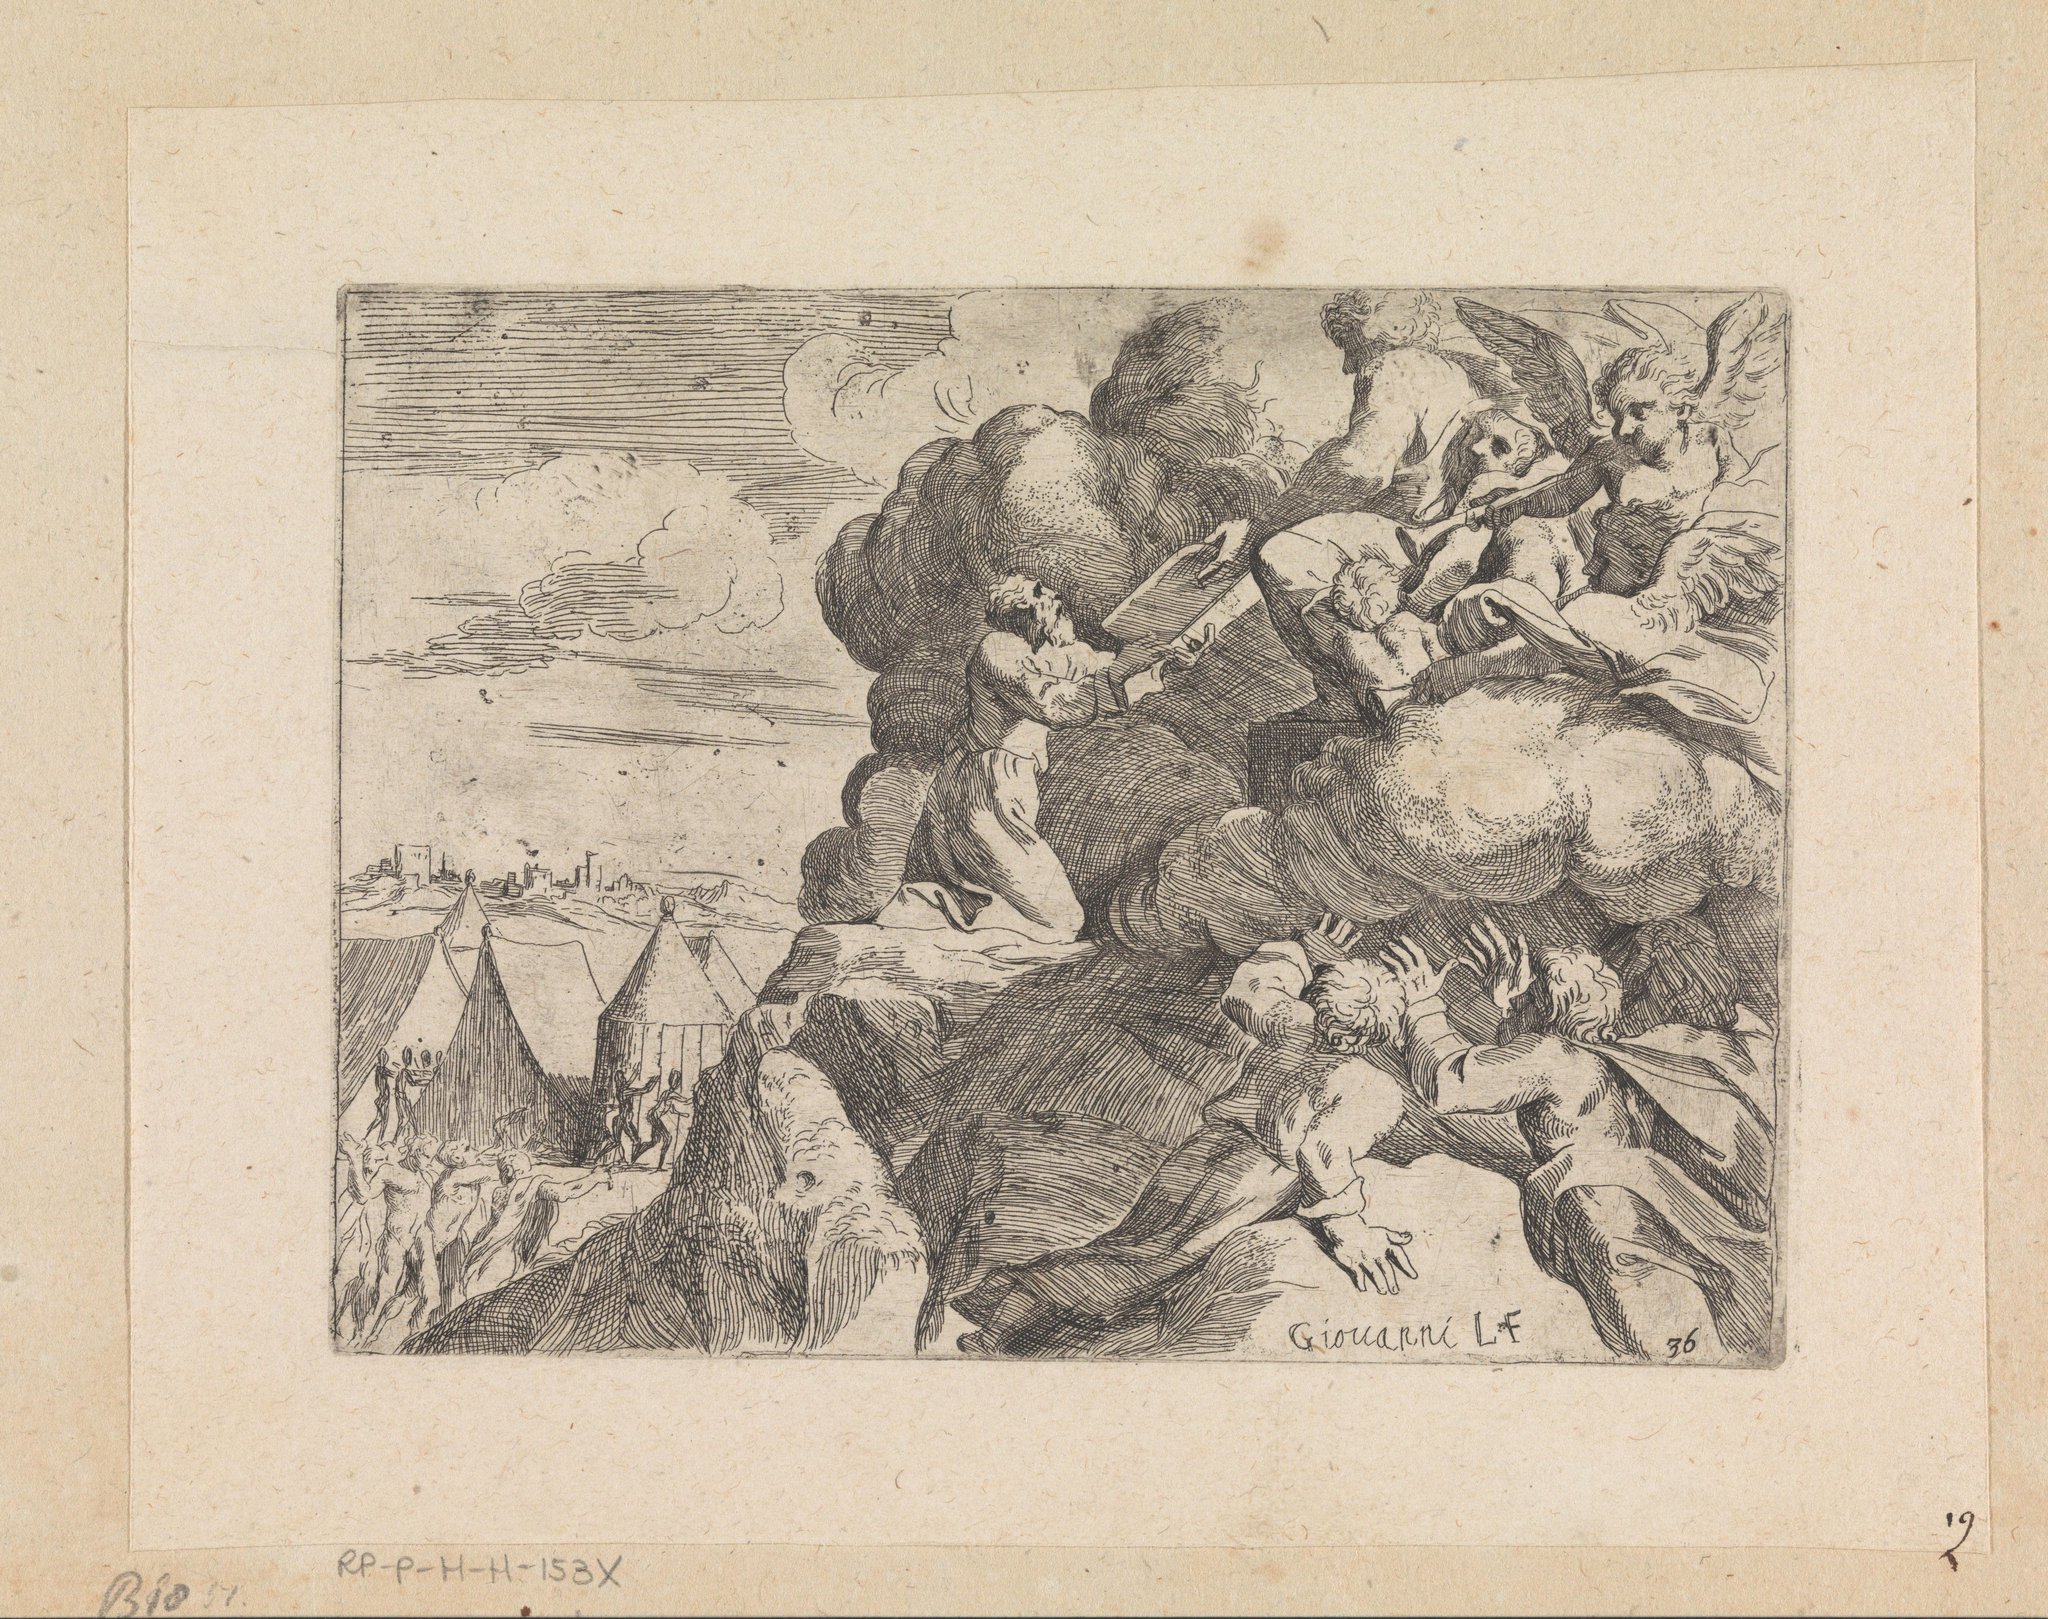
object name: print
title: Historia del Testamento Vecchio / Dipinta in Roma nel Vaticano da Raffaelle di Urbin (...)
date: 1607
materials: paper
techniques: etching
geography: italy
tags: moses on mount sinai with the tables of the law (exodus 24:9-18, 31:18)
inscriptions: collector's mark: ‘Hinloopen’, number: ‘19’, collector's mark: Lugt 11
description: Op een blad geplakt met rechtsboven handgeschreven in pen in bruin: 139. Prent uit een reeks van 54 genummerde prenten naar schilderingen in de Loggia van Rafael in het Vaticaan.